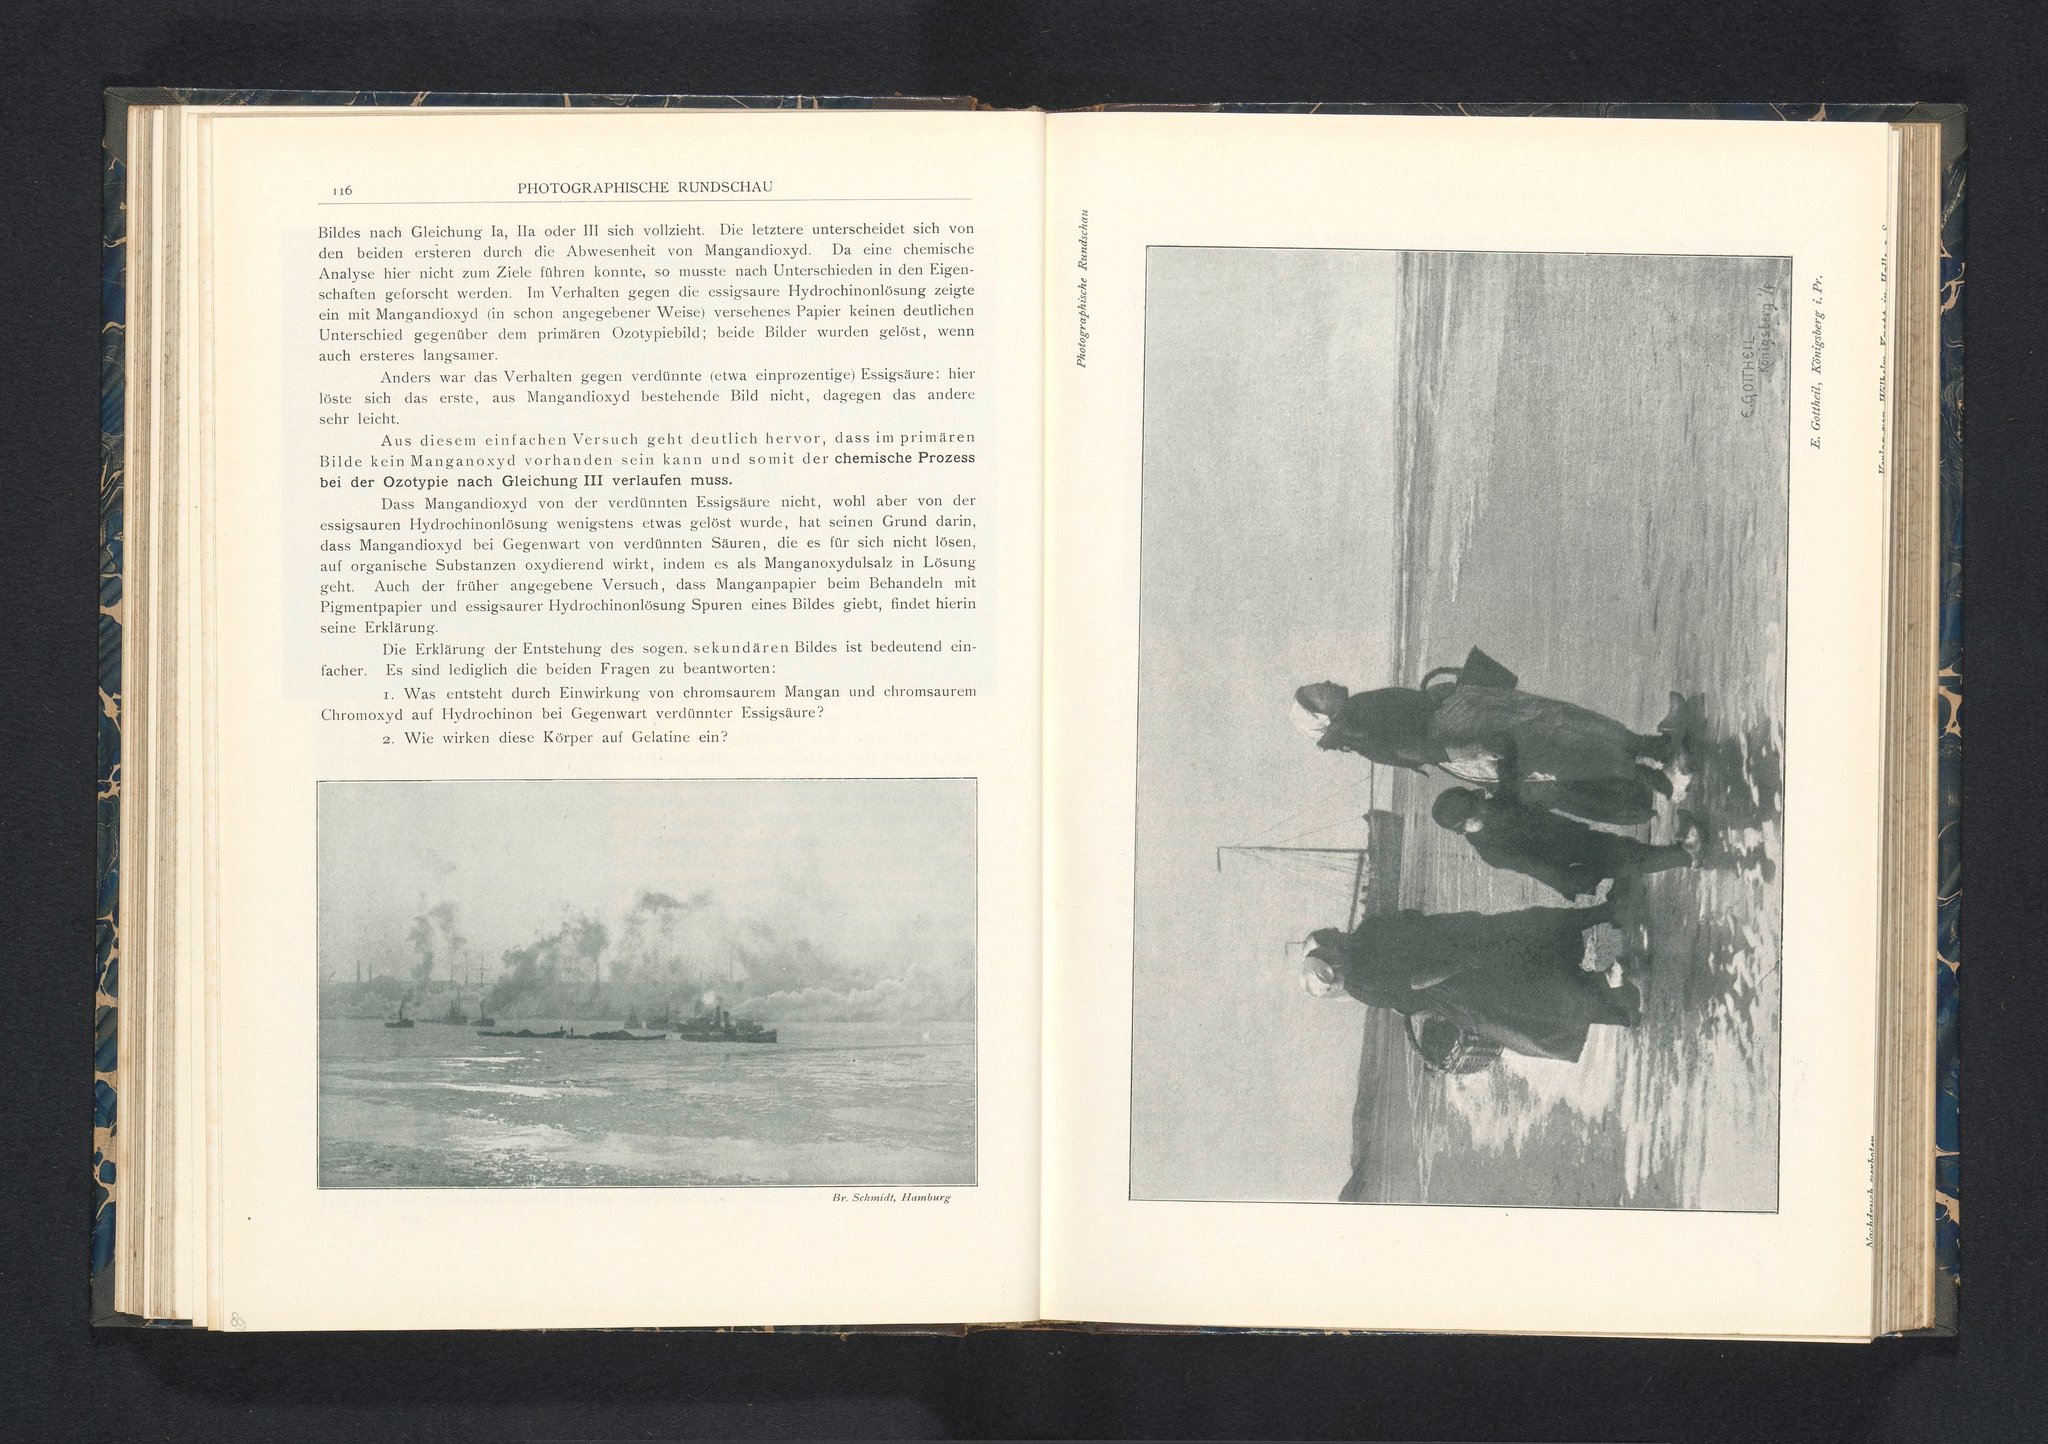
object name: photomechanical print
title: Drie vrouwen en een kind staan in de branding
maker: elias gottheil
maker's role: fotograaf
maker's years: 1820-1899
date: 1896-1901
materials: paper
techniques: autotype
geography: halle an der saale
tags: adult woman, child, coast